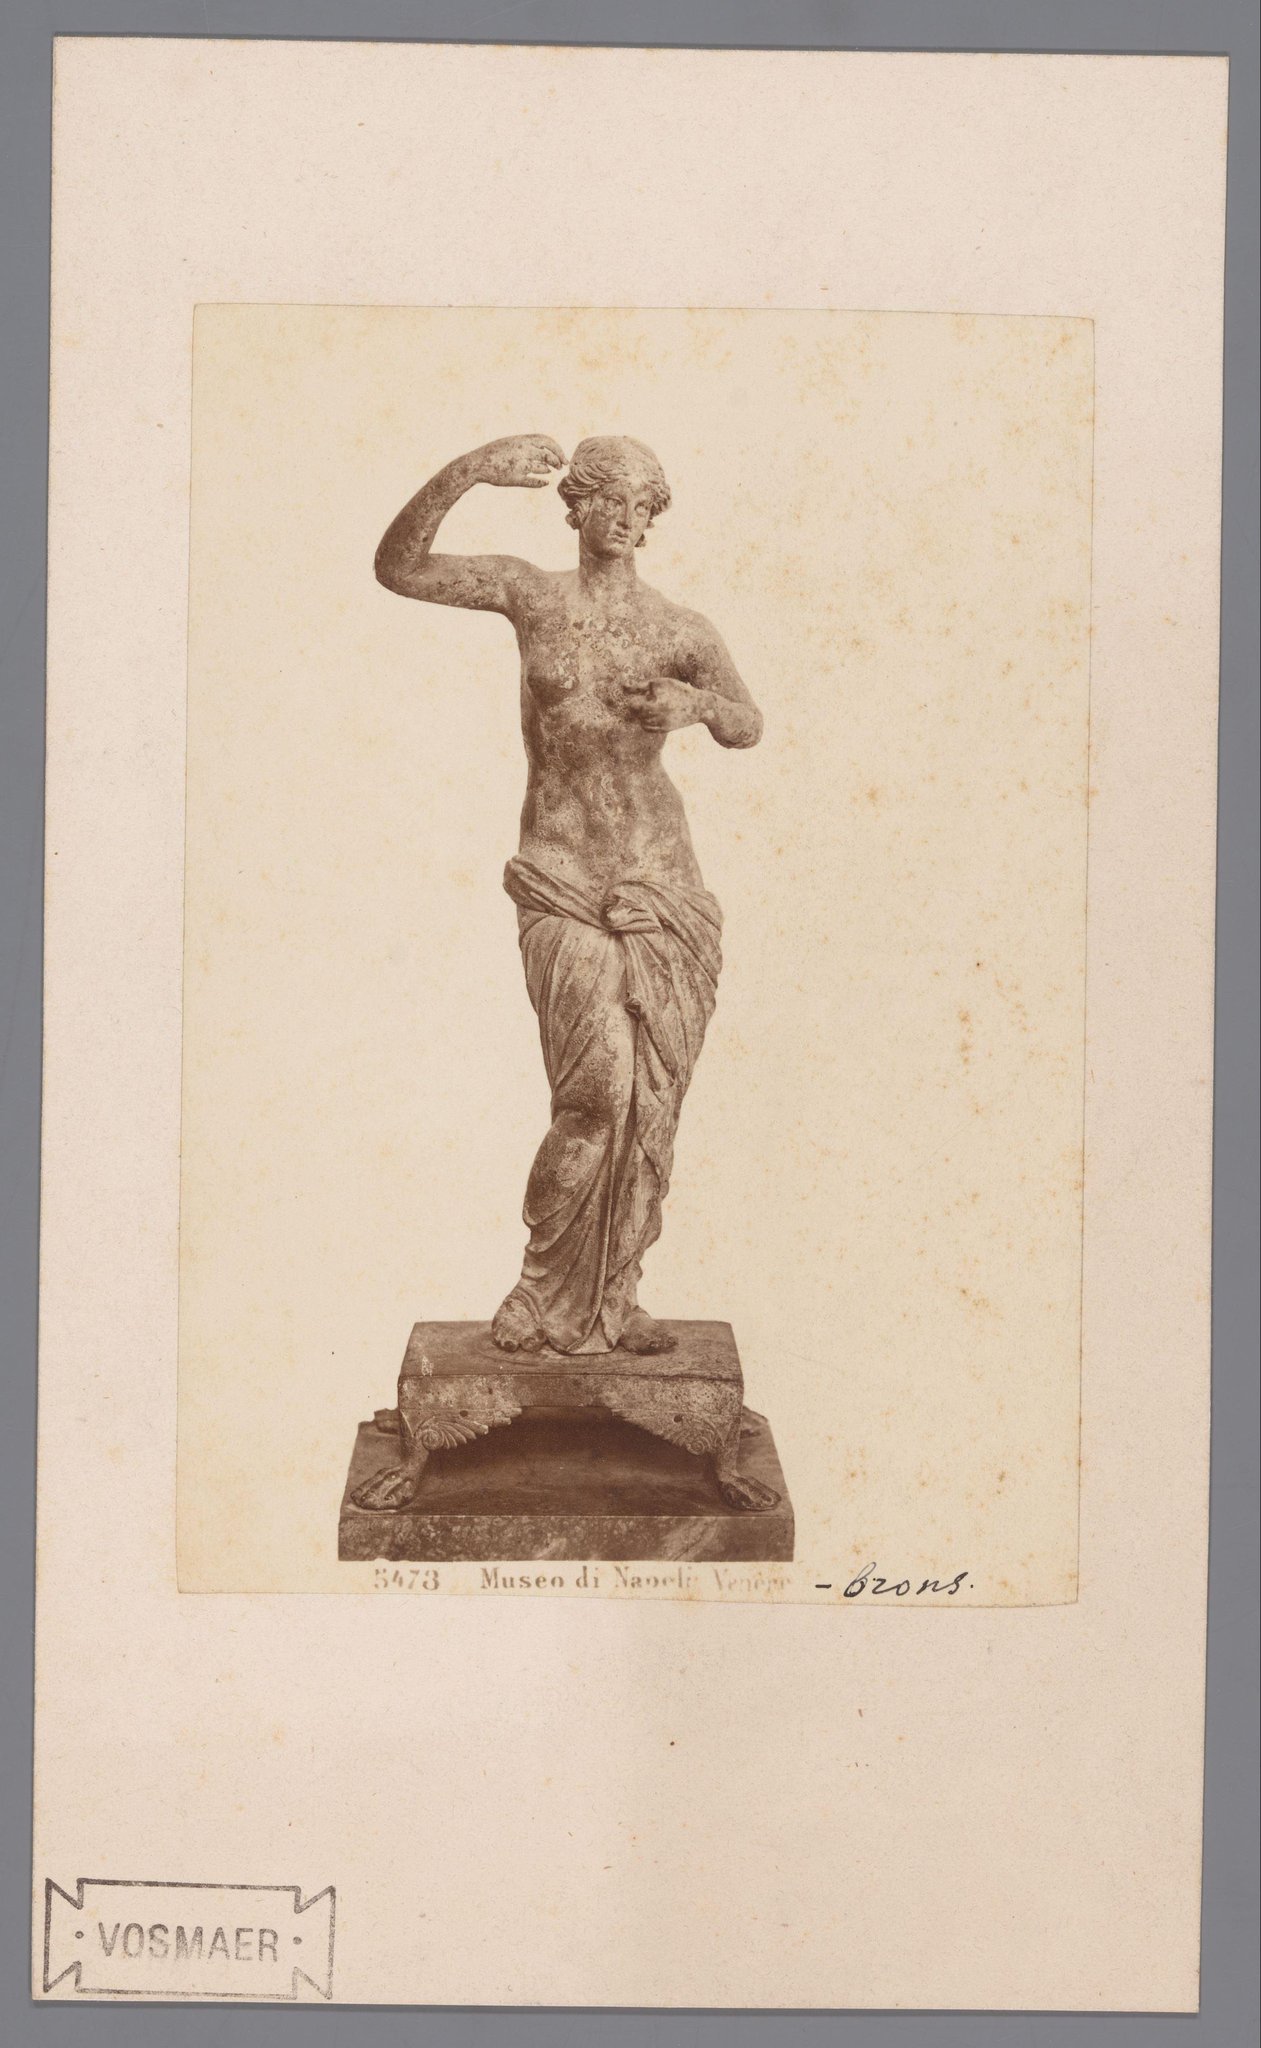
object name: photograph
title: Venège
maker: Anonymous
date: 1870-1890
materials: cardboard, paper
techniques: albumen print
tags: piece of sculpture, reproduction of a piece of sculpture, (story of) venus (aphrodite)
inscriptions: inscription: ‘-Brons.’, collector's mark: ‘VOSMAER’, number: ‘5473’